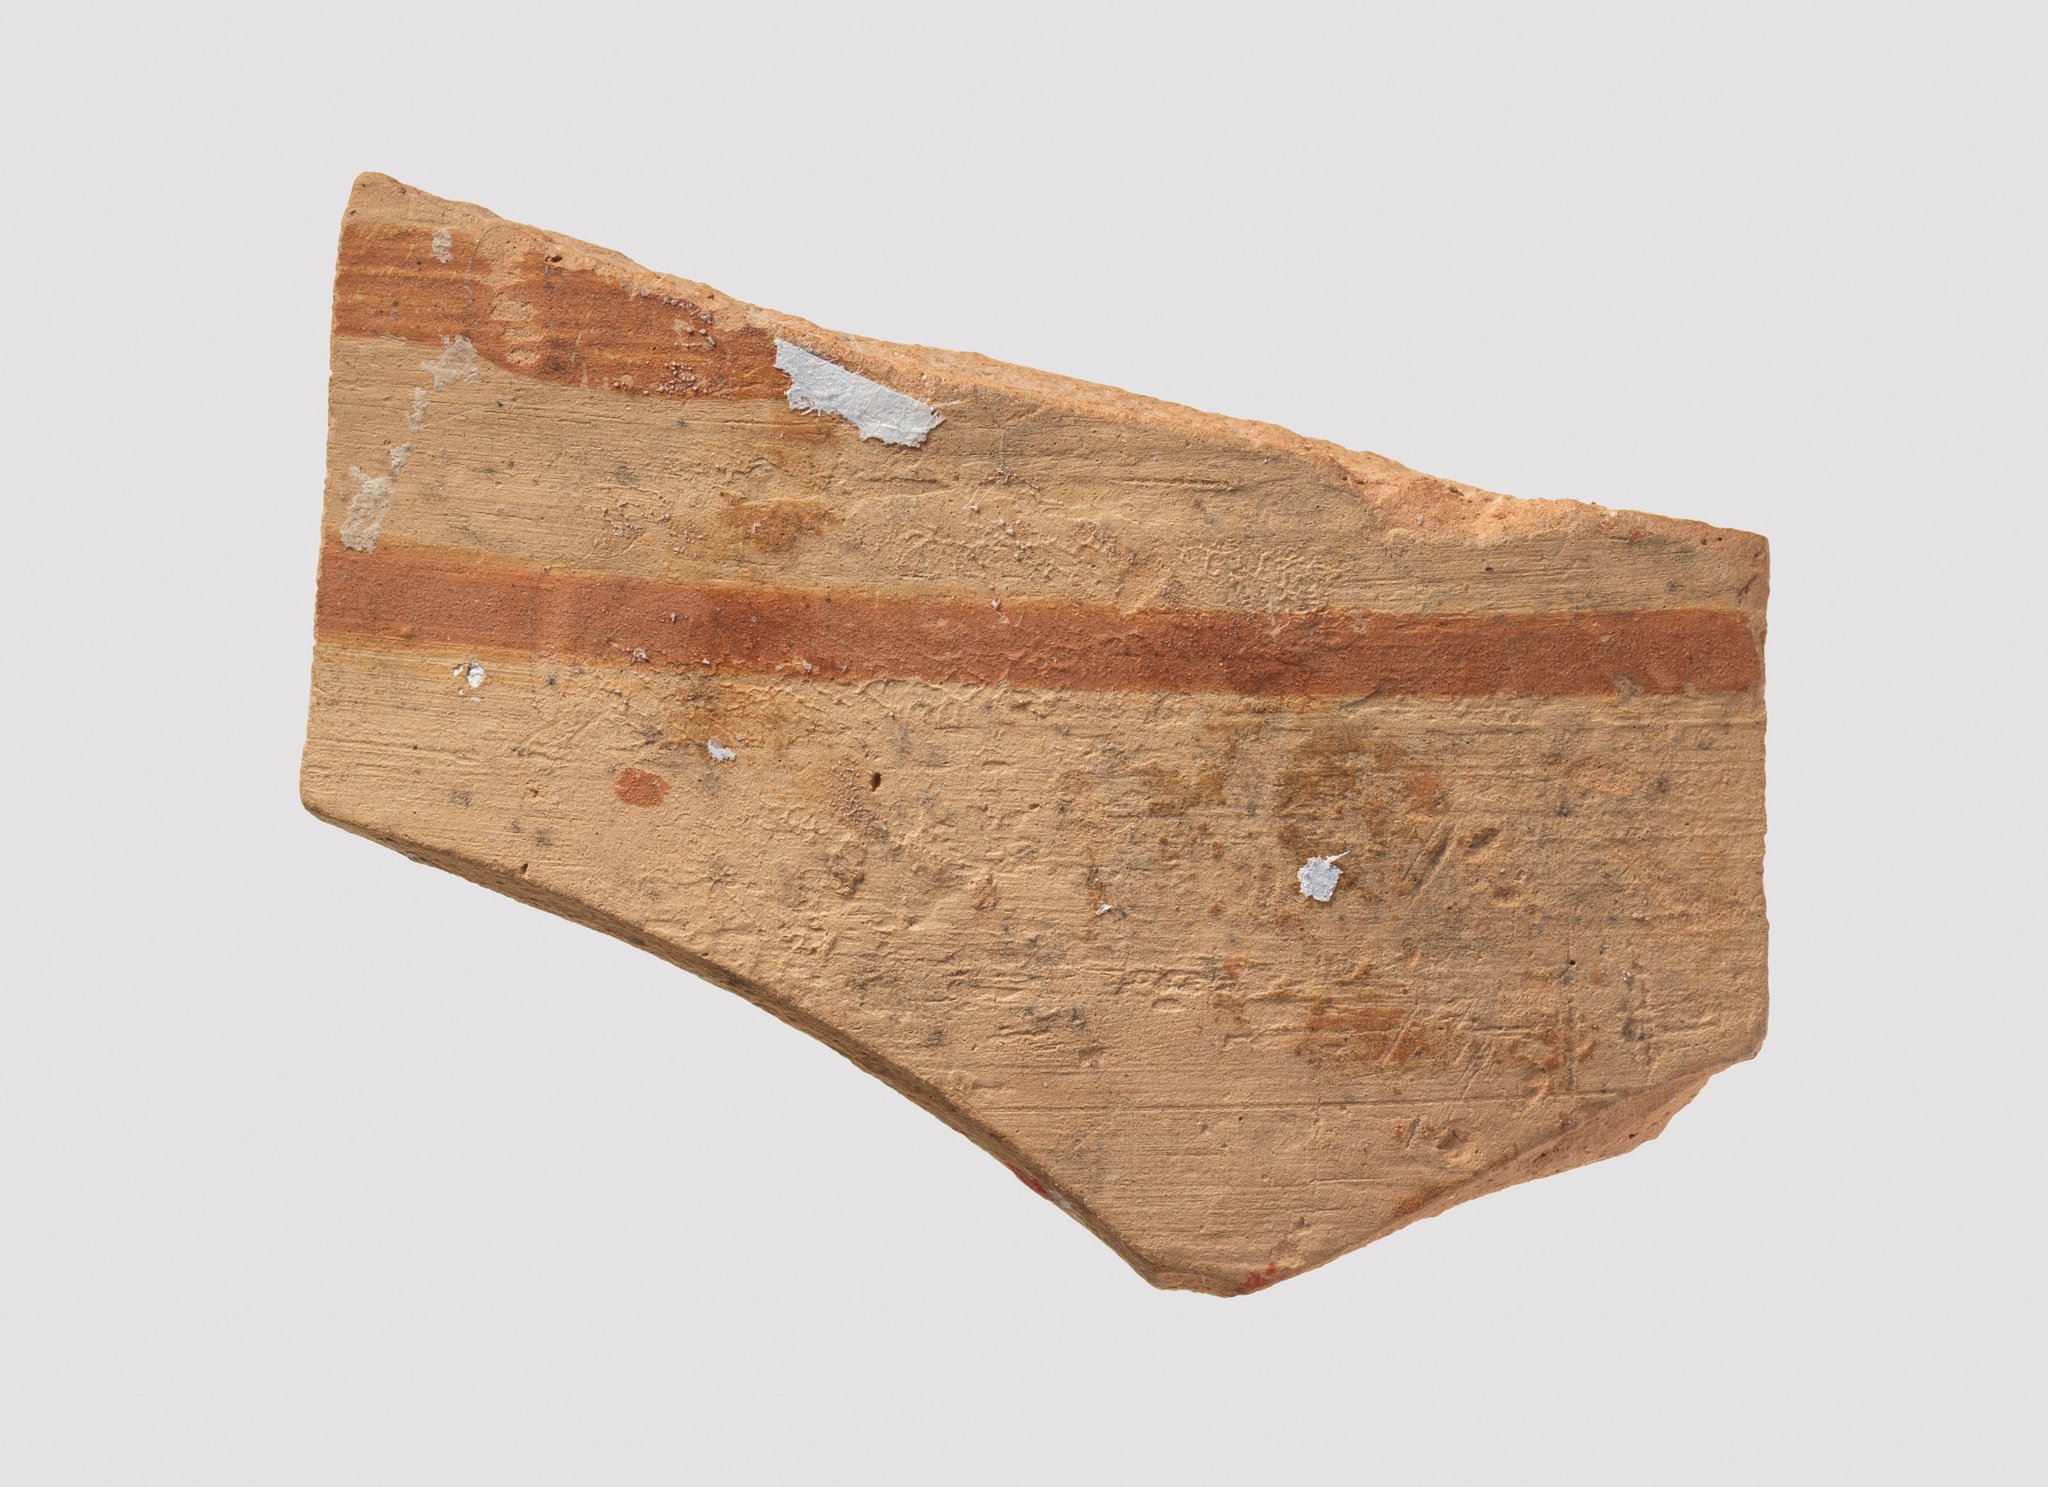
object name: sherd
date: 2000-1668 BCE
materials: ceramic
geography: mesopotamia